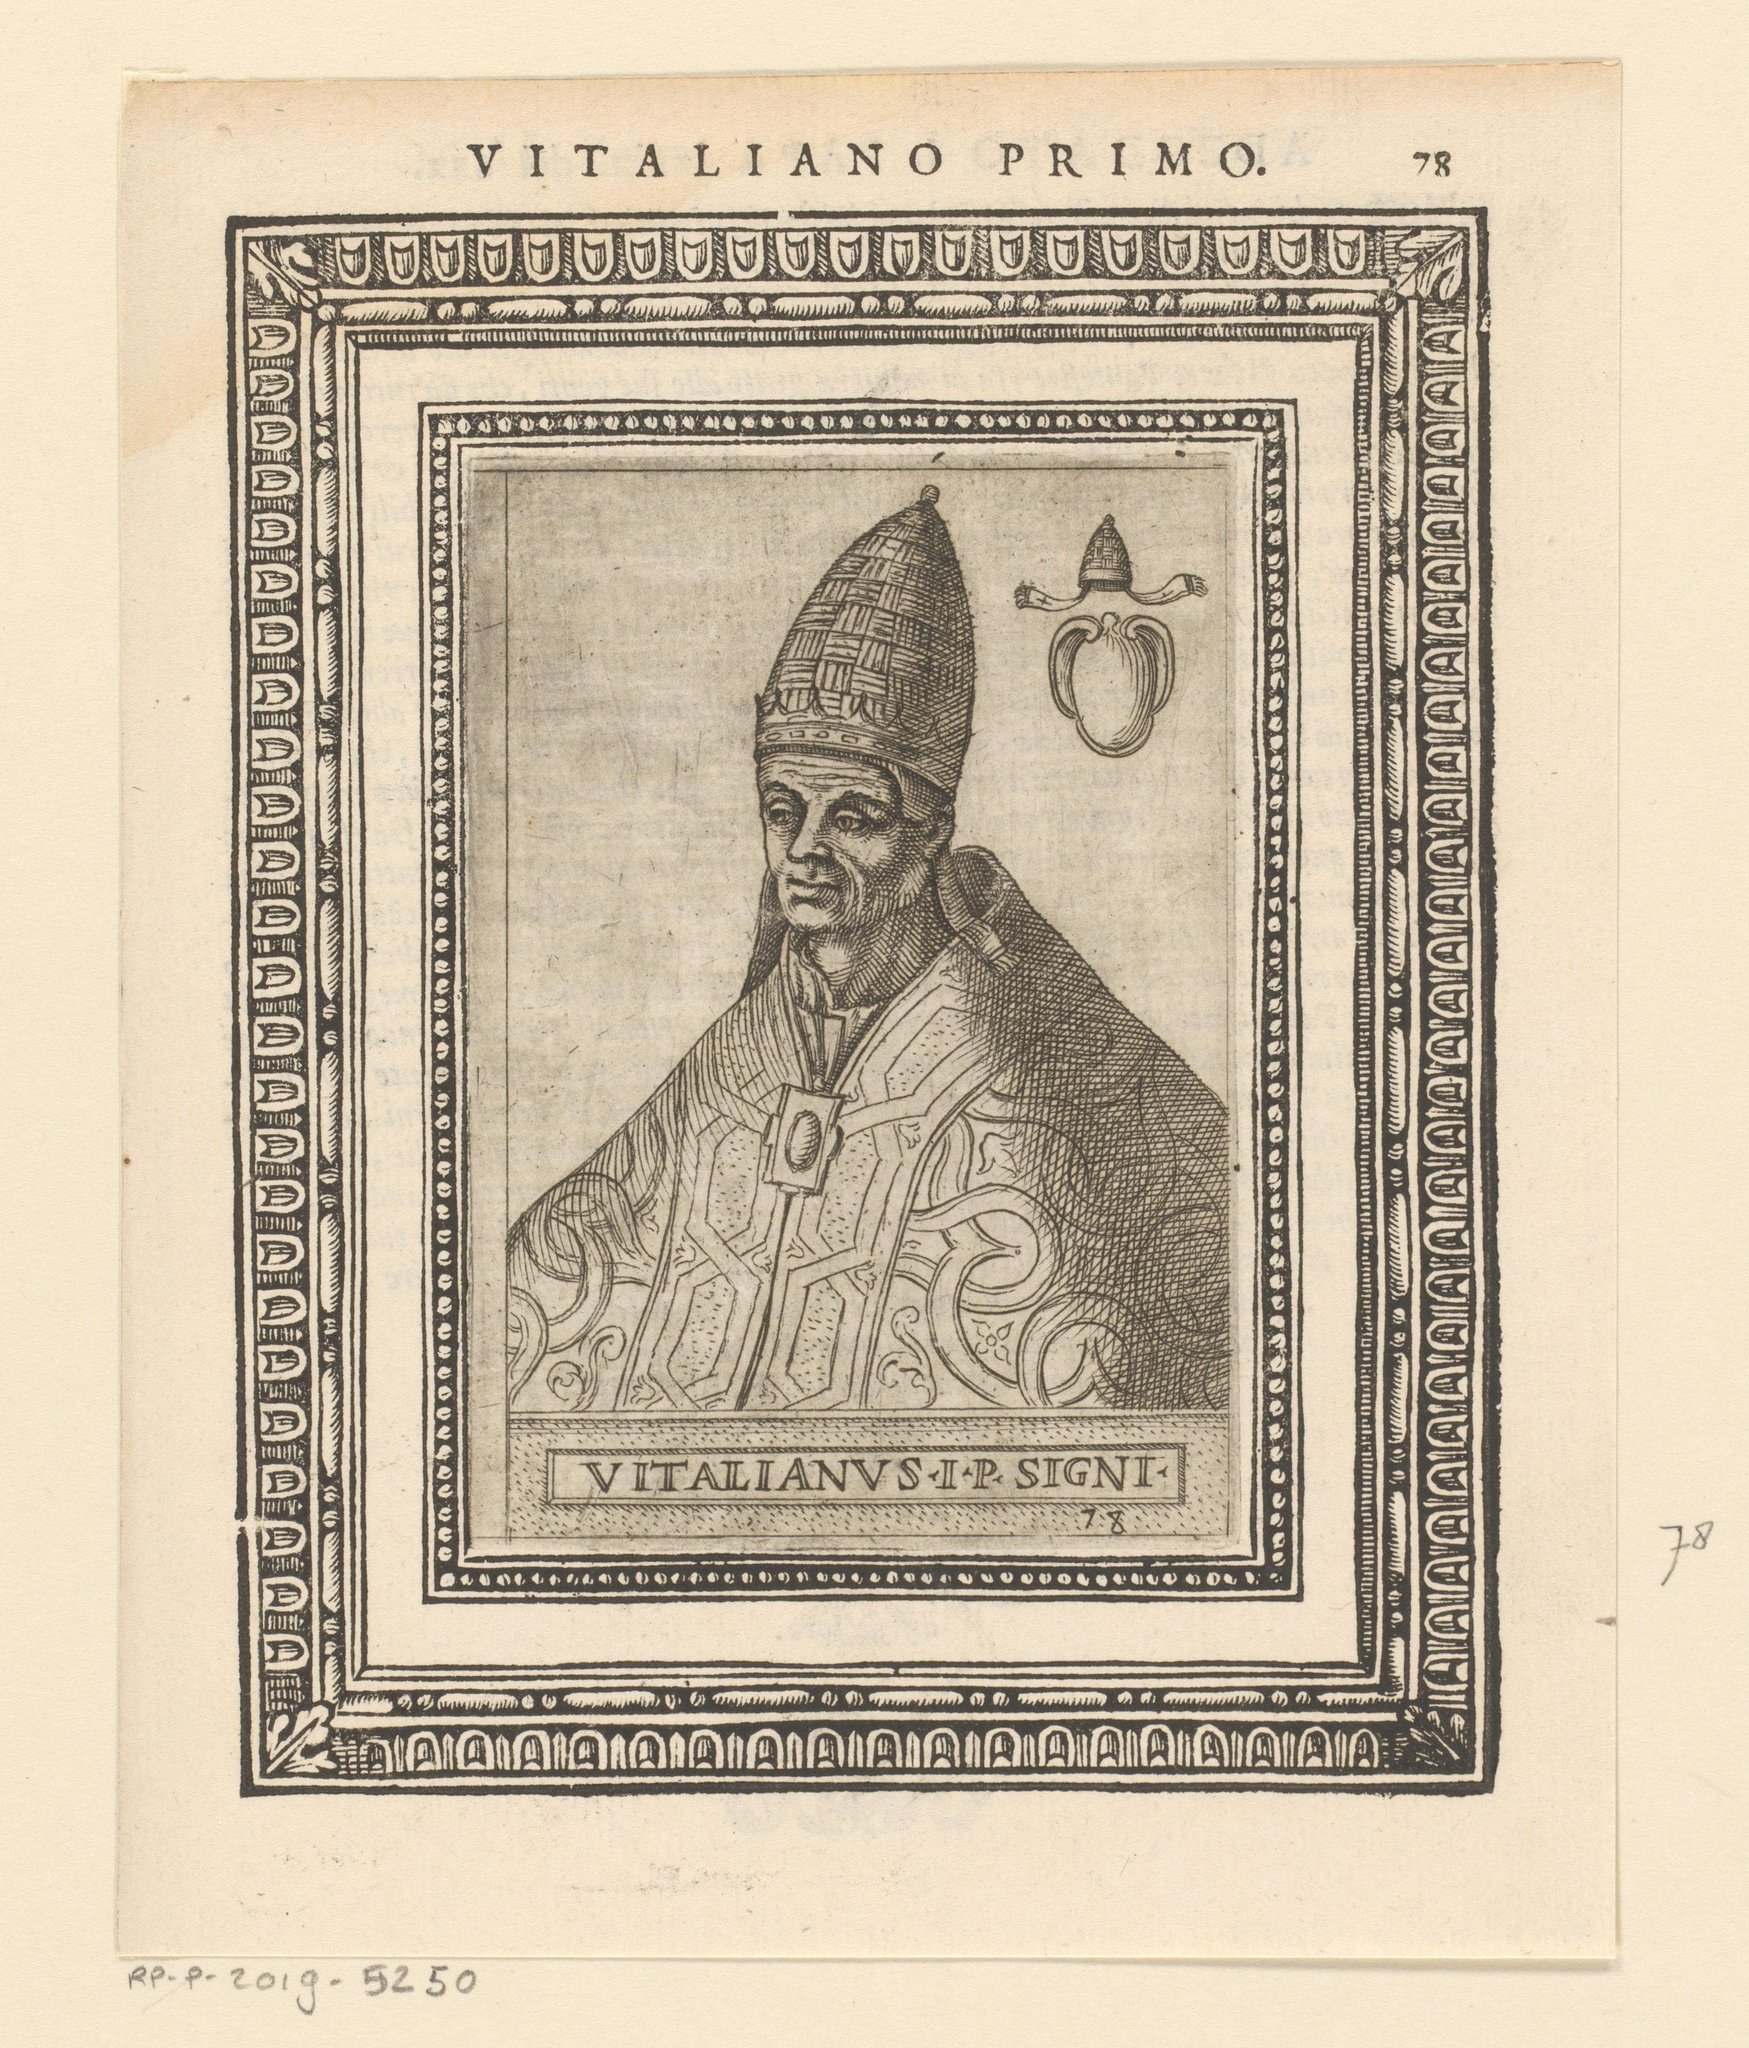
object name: book illustration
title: Portret van paus Vitalianus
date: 1587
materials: paper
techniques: engraving, letterpress printing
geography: rome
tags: historical persons, pope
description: Prent uit: Ciccarelli, Antonio. Le vite de Pontefici di Antonio Ciccarelli (...). Rome: Domenico Basa, 1587. Prent voor het eerst verschenen in: Cavalieri, Giovanni Battista de'. Pontificum romanorum effigies (...). Rome: Domenico Basa en Francesco Zanetti, 1580. Prent ook gebruikt in latere publicaties.